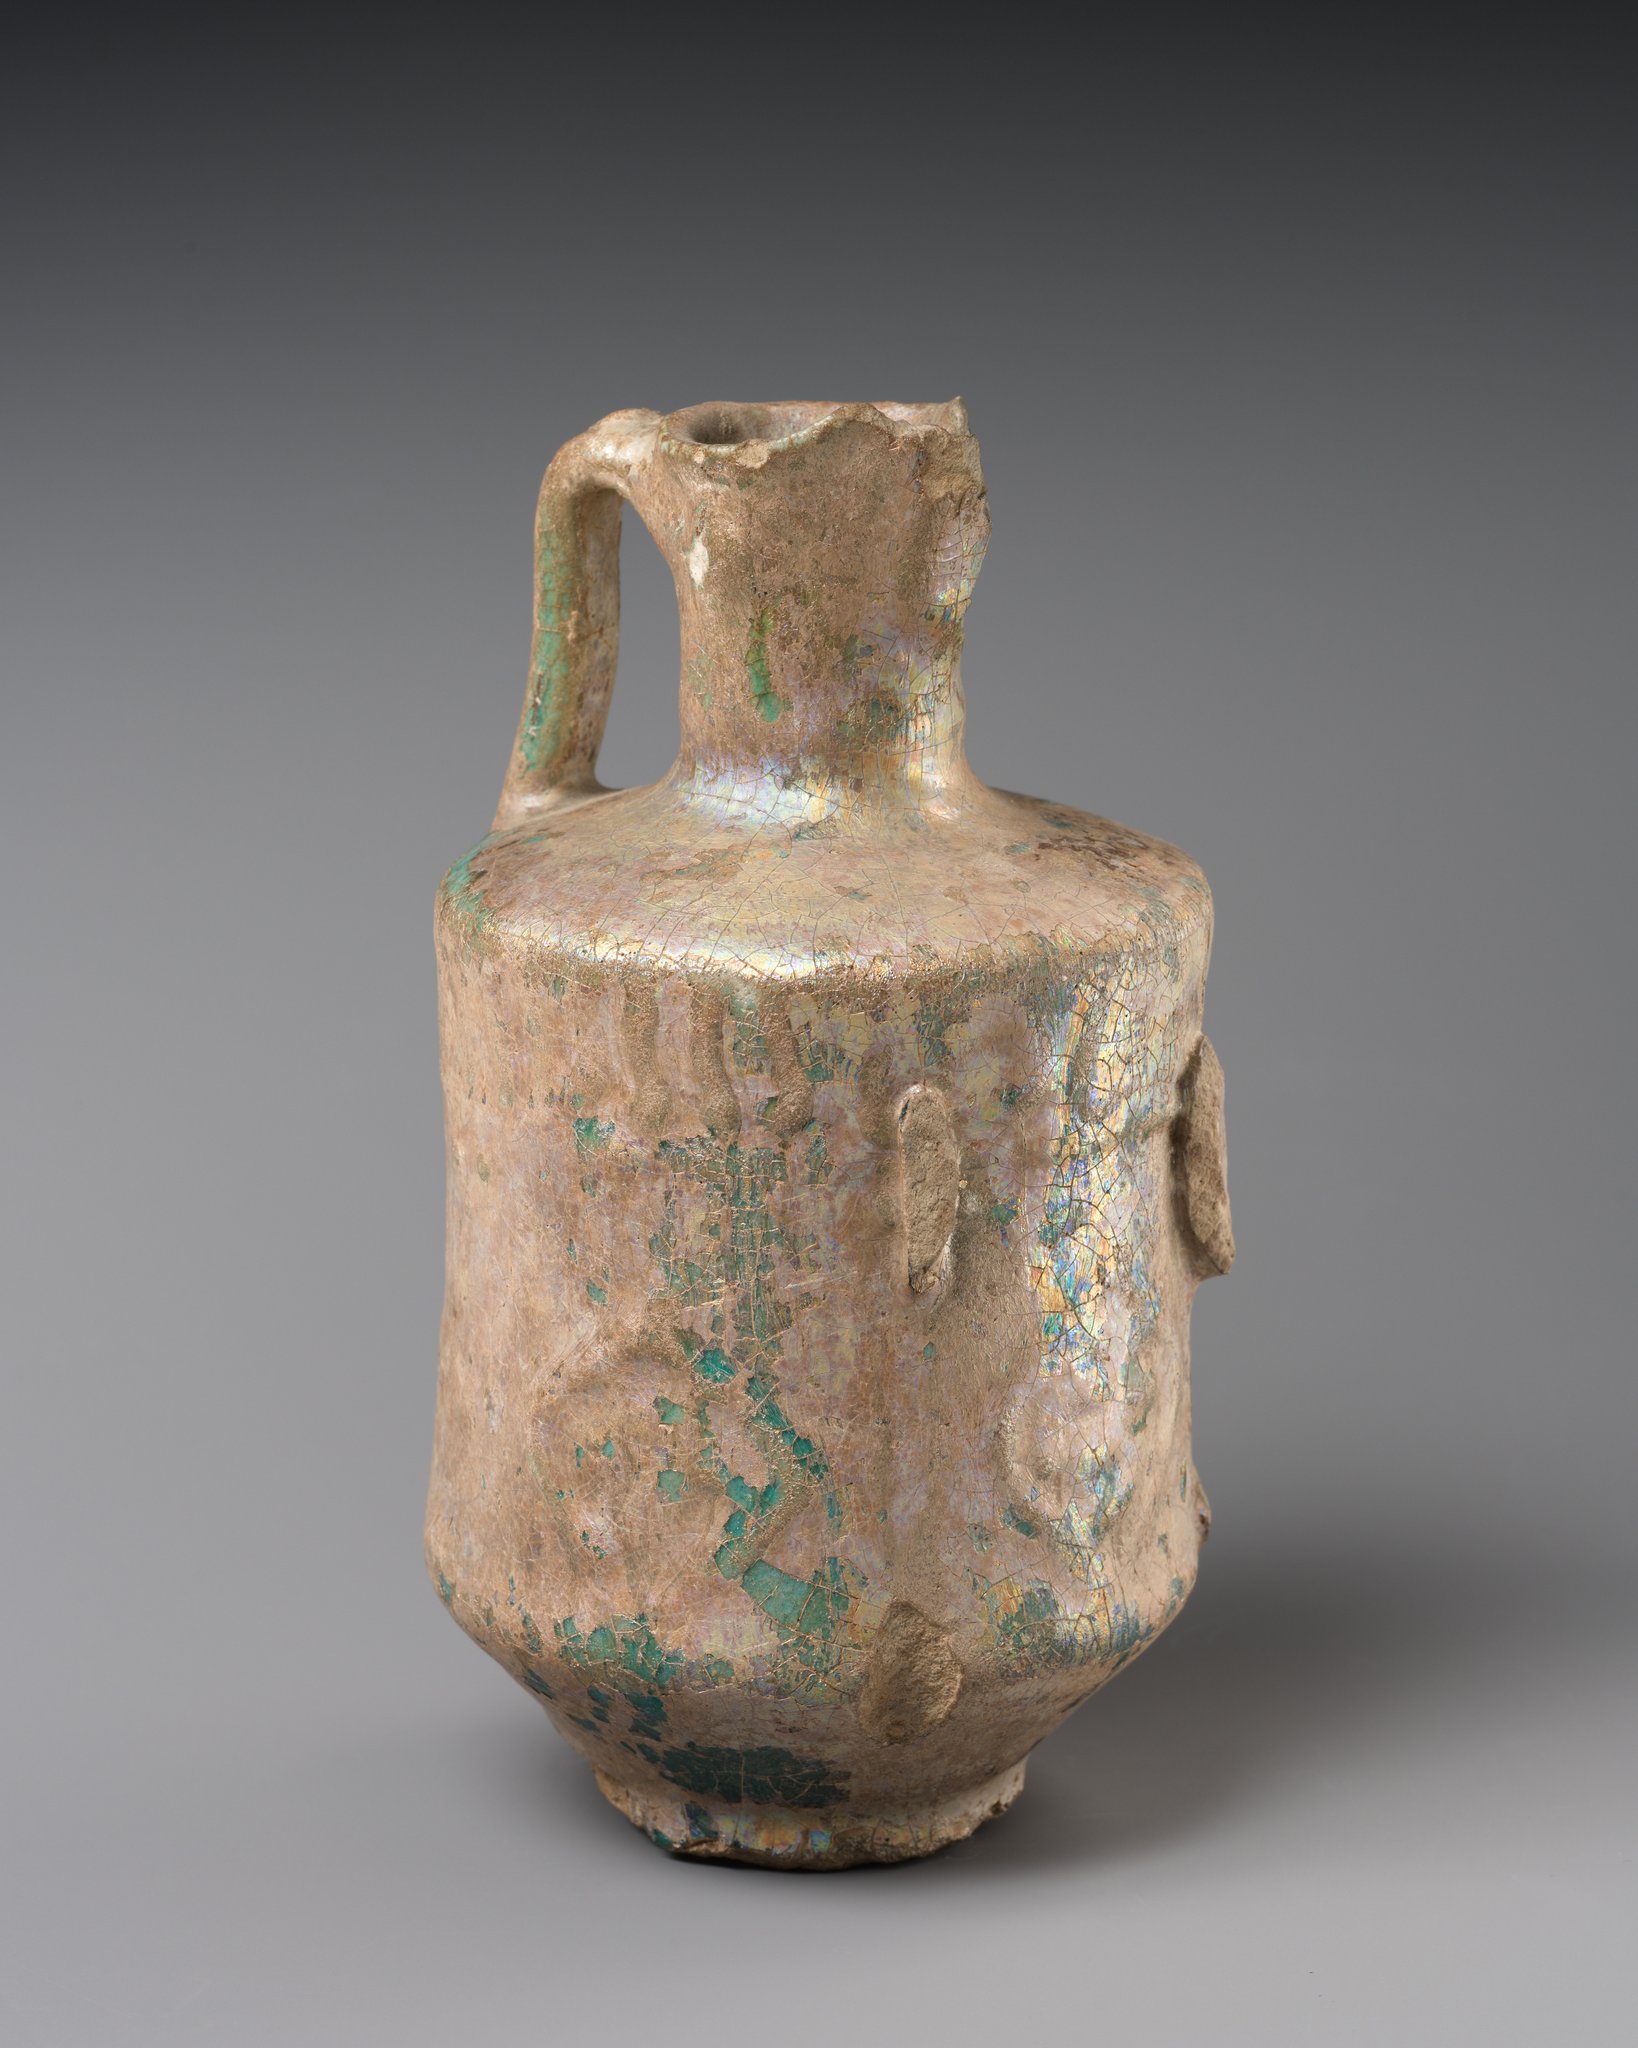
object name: ewer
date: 1201-1300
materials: stonepaste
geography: syria